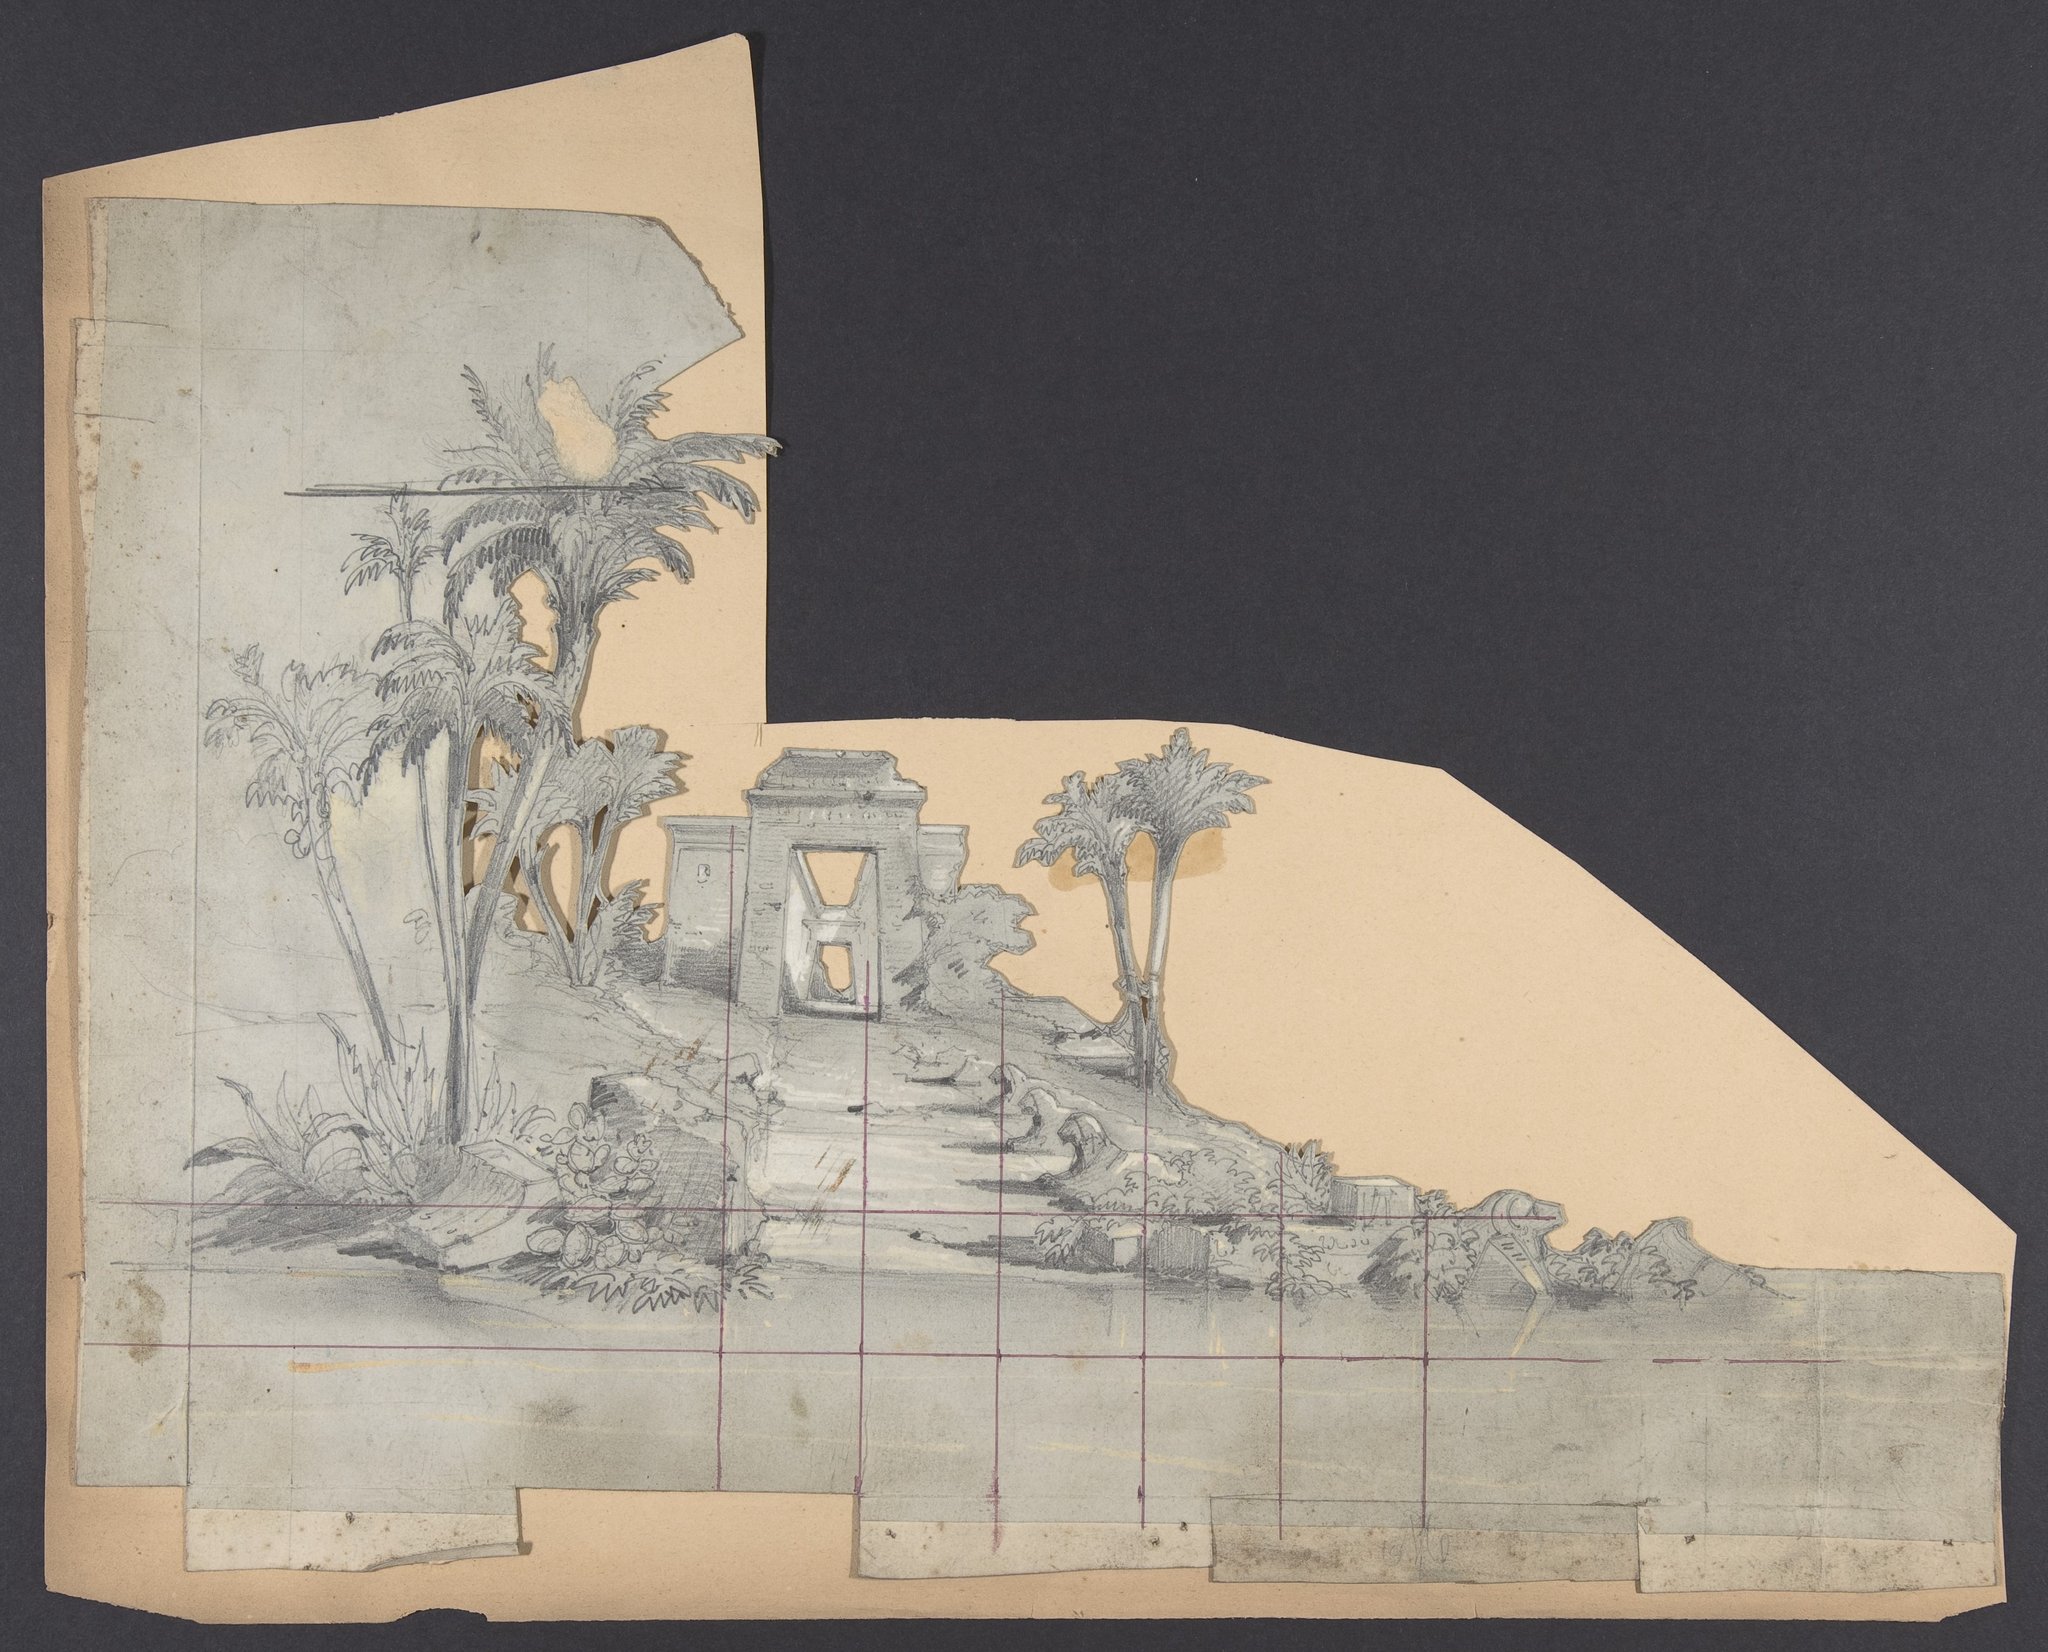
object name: drawing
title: Design for a Stage Set at the Opéra, Paris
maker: eugène cicéri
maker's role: artist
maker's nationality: french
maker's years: 1813-1890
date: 1830-1890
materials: graphite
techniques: heightening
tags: trees,stage design